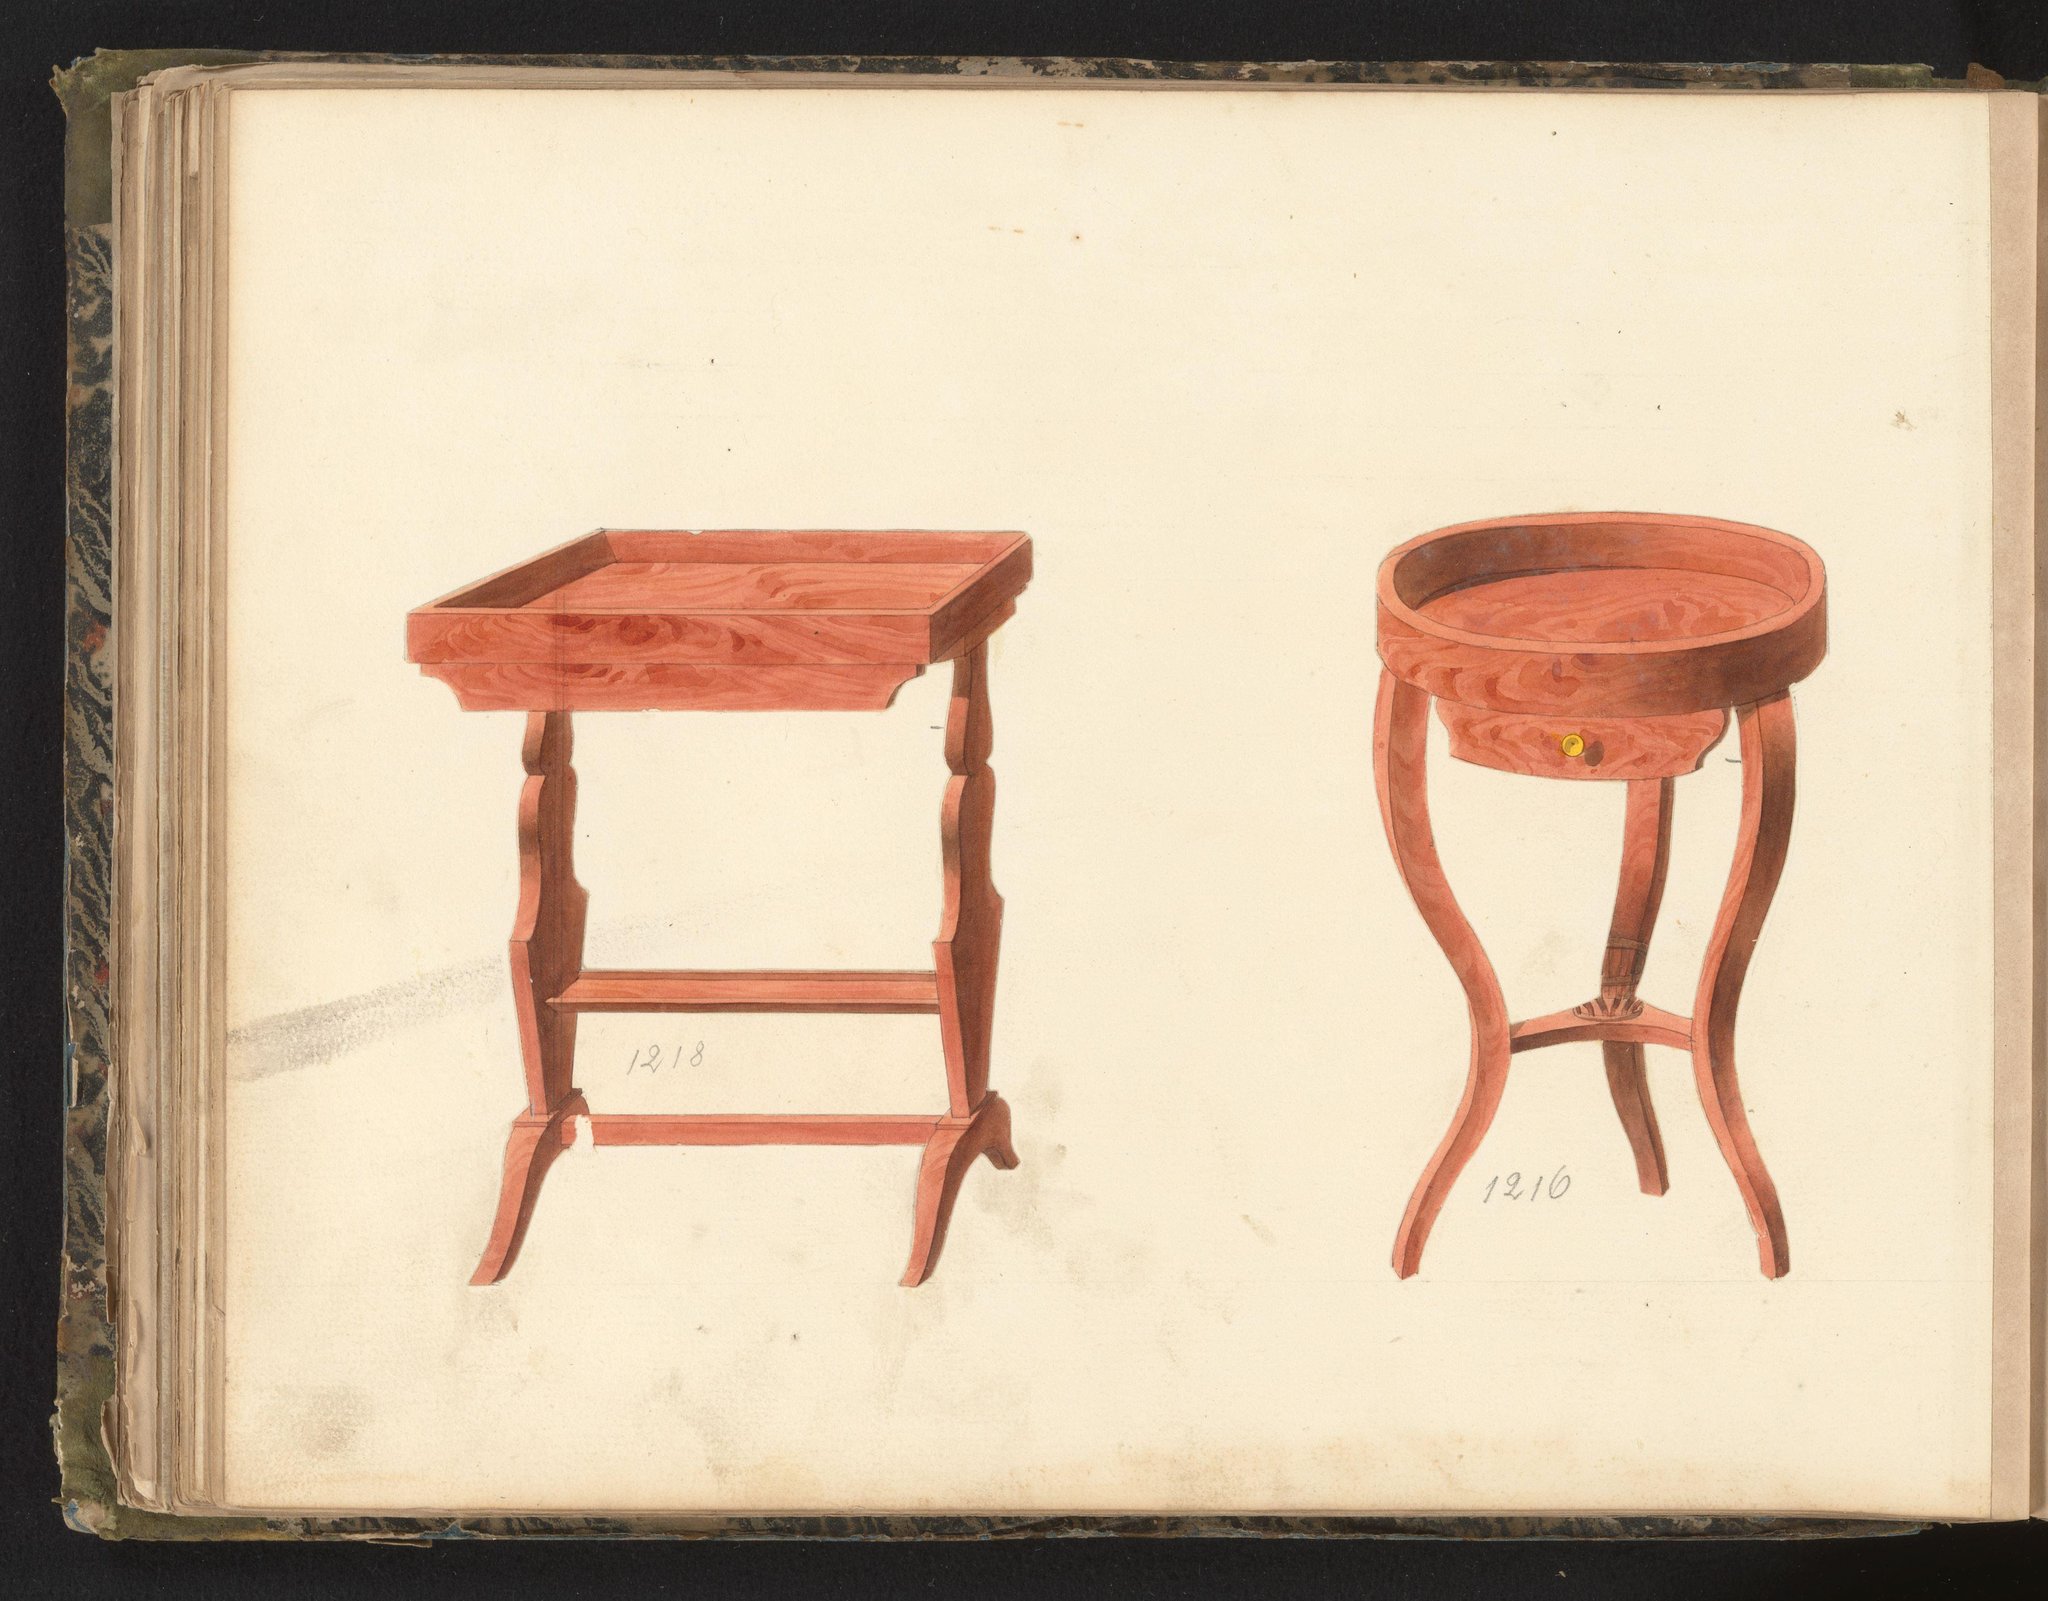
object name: drawing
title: Twee ontwerpen voor breitafels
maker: Anonymous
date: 1825-1839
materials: ink, paper, pencil, watercolor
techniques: brush, pen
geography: paris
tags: table (+ wood and other phytogenic material), (other forms of) needlework, e.g.: crocheting, knitting, embroidering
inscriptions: inscription: ‘1216 Tricoteuse Ronde pieds rentré 1218 Tricoteuse carrée à pied à Lyre’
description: Twee ontwerpen voor breitafels (tricoteuse) in mahoniehout. Het blad op de achterzijde genummerd: 22, het tegenoverliggende blad met informatie over de afgebeelde meubelen genummerd: 22 bis. Onderdeel van een album met 80 bladen met tekeningen en een prent van gefineerde en gelakte meubelen, alsmede zitmeubelen.